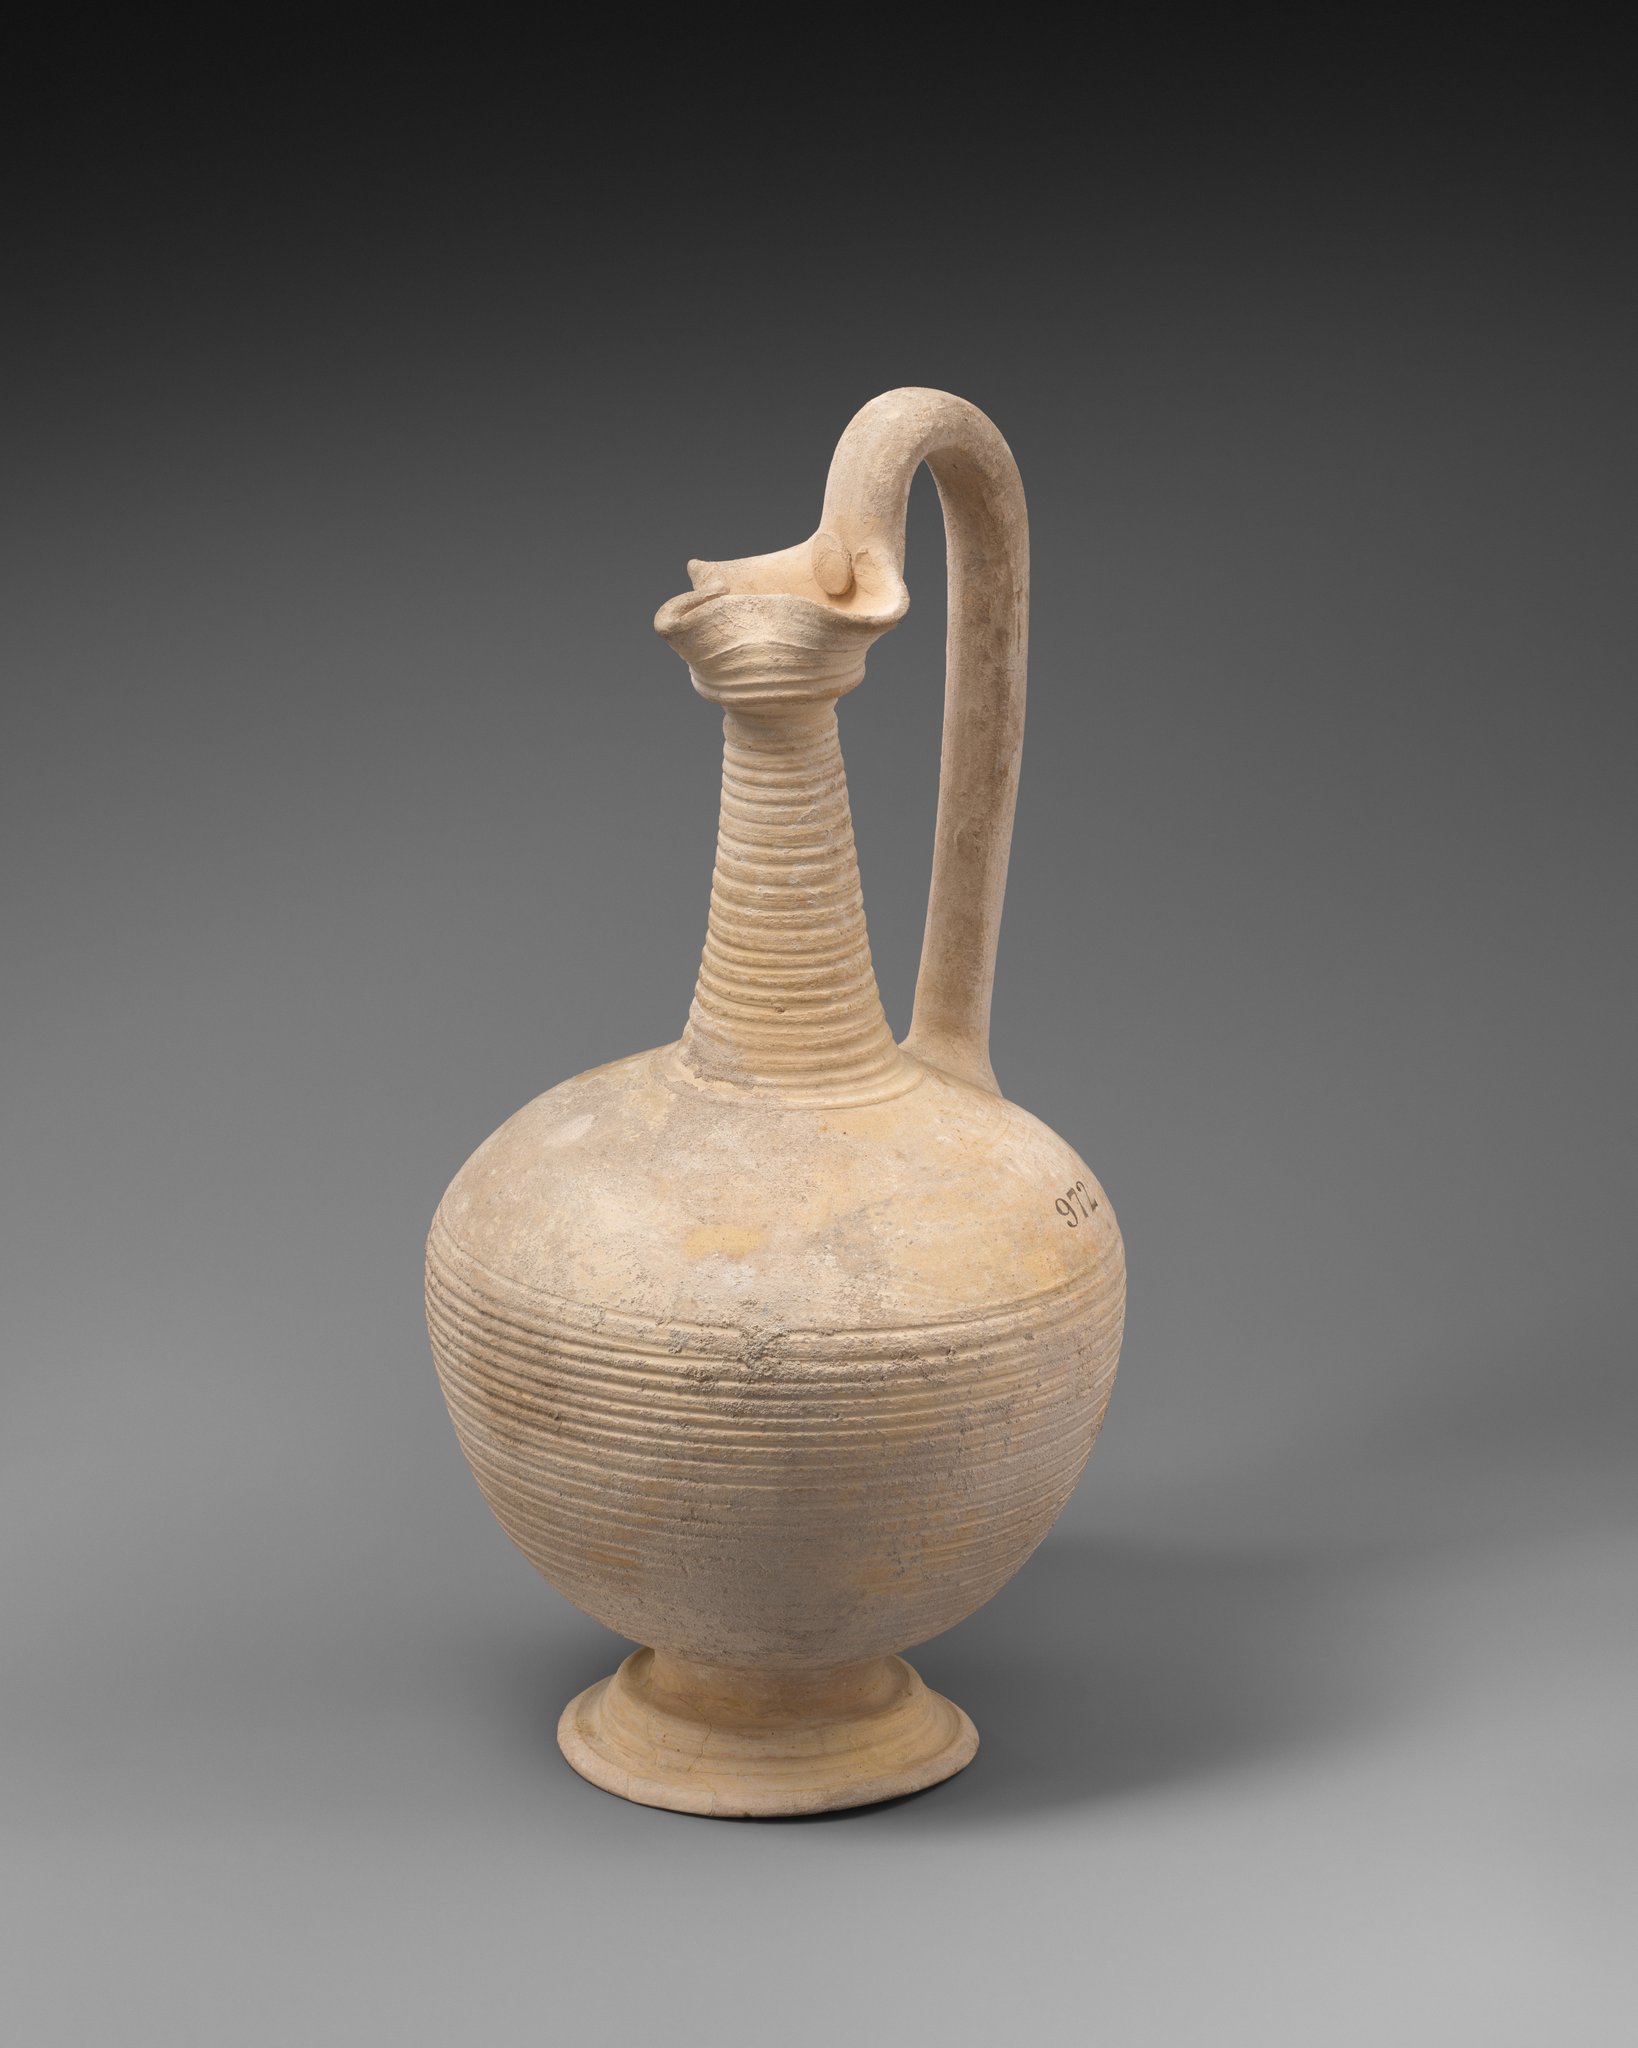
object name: jug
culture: cypriot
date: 400-310 BCE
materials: terracotta